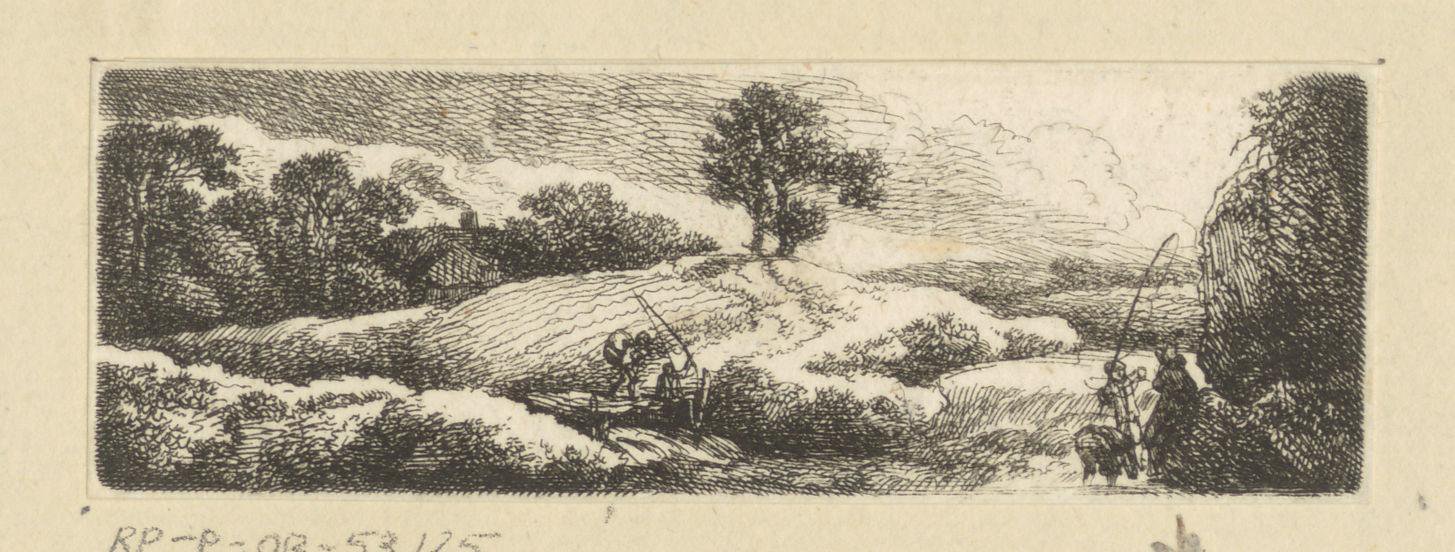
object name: print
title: Landschap met vissers bij een stroomversnelling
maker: johann christian klengel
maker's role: print maker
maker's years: 1751-1824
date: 1761-1824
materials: paper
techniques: etching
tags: rural housing, e.g. country-house, villa, cottage, spring, source of river or stream, fisherman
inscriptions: collector's mark: Lugt 240